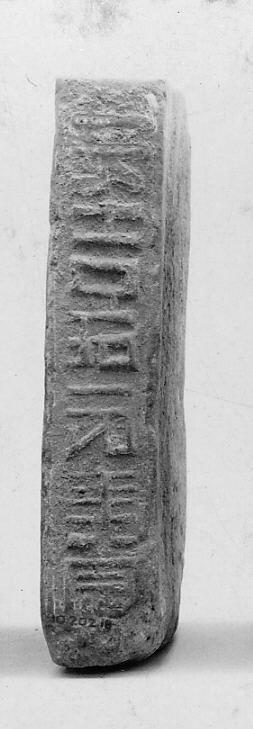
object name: tile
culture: chinese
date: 221 BCE-220 CE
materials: earthenware